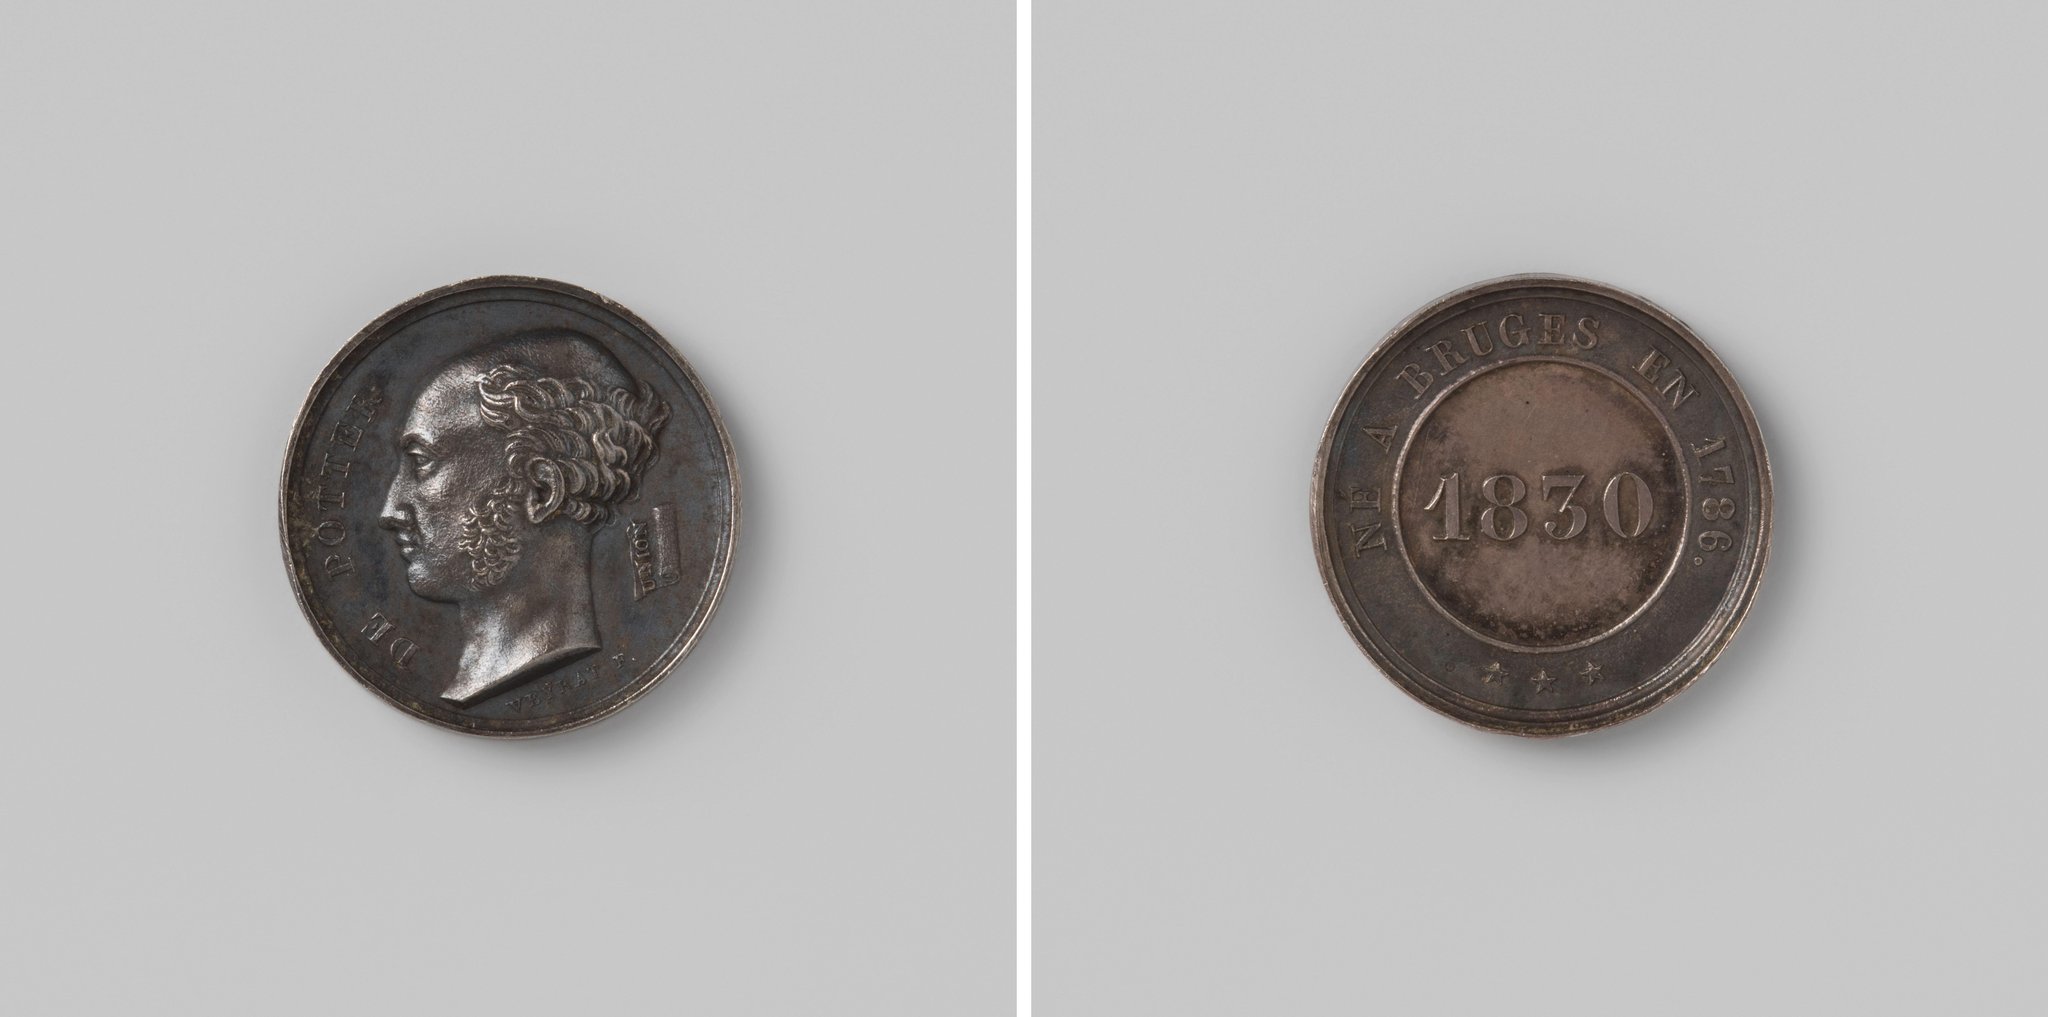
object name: history medal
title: Louis Joseph de Potter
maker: adrien hippolyte veyrat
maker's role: medailleur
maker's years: 1803-1883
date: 1830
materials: silver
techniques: striking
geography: brussels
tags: bruges, politician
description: Zilveren penning. Voorzijde: borststuk man; rechts daarvan een voor de helft ontrold papier met opschrift binnen omschrift. Keerzijde: jaartal binnen omschrift.